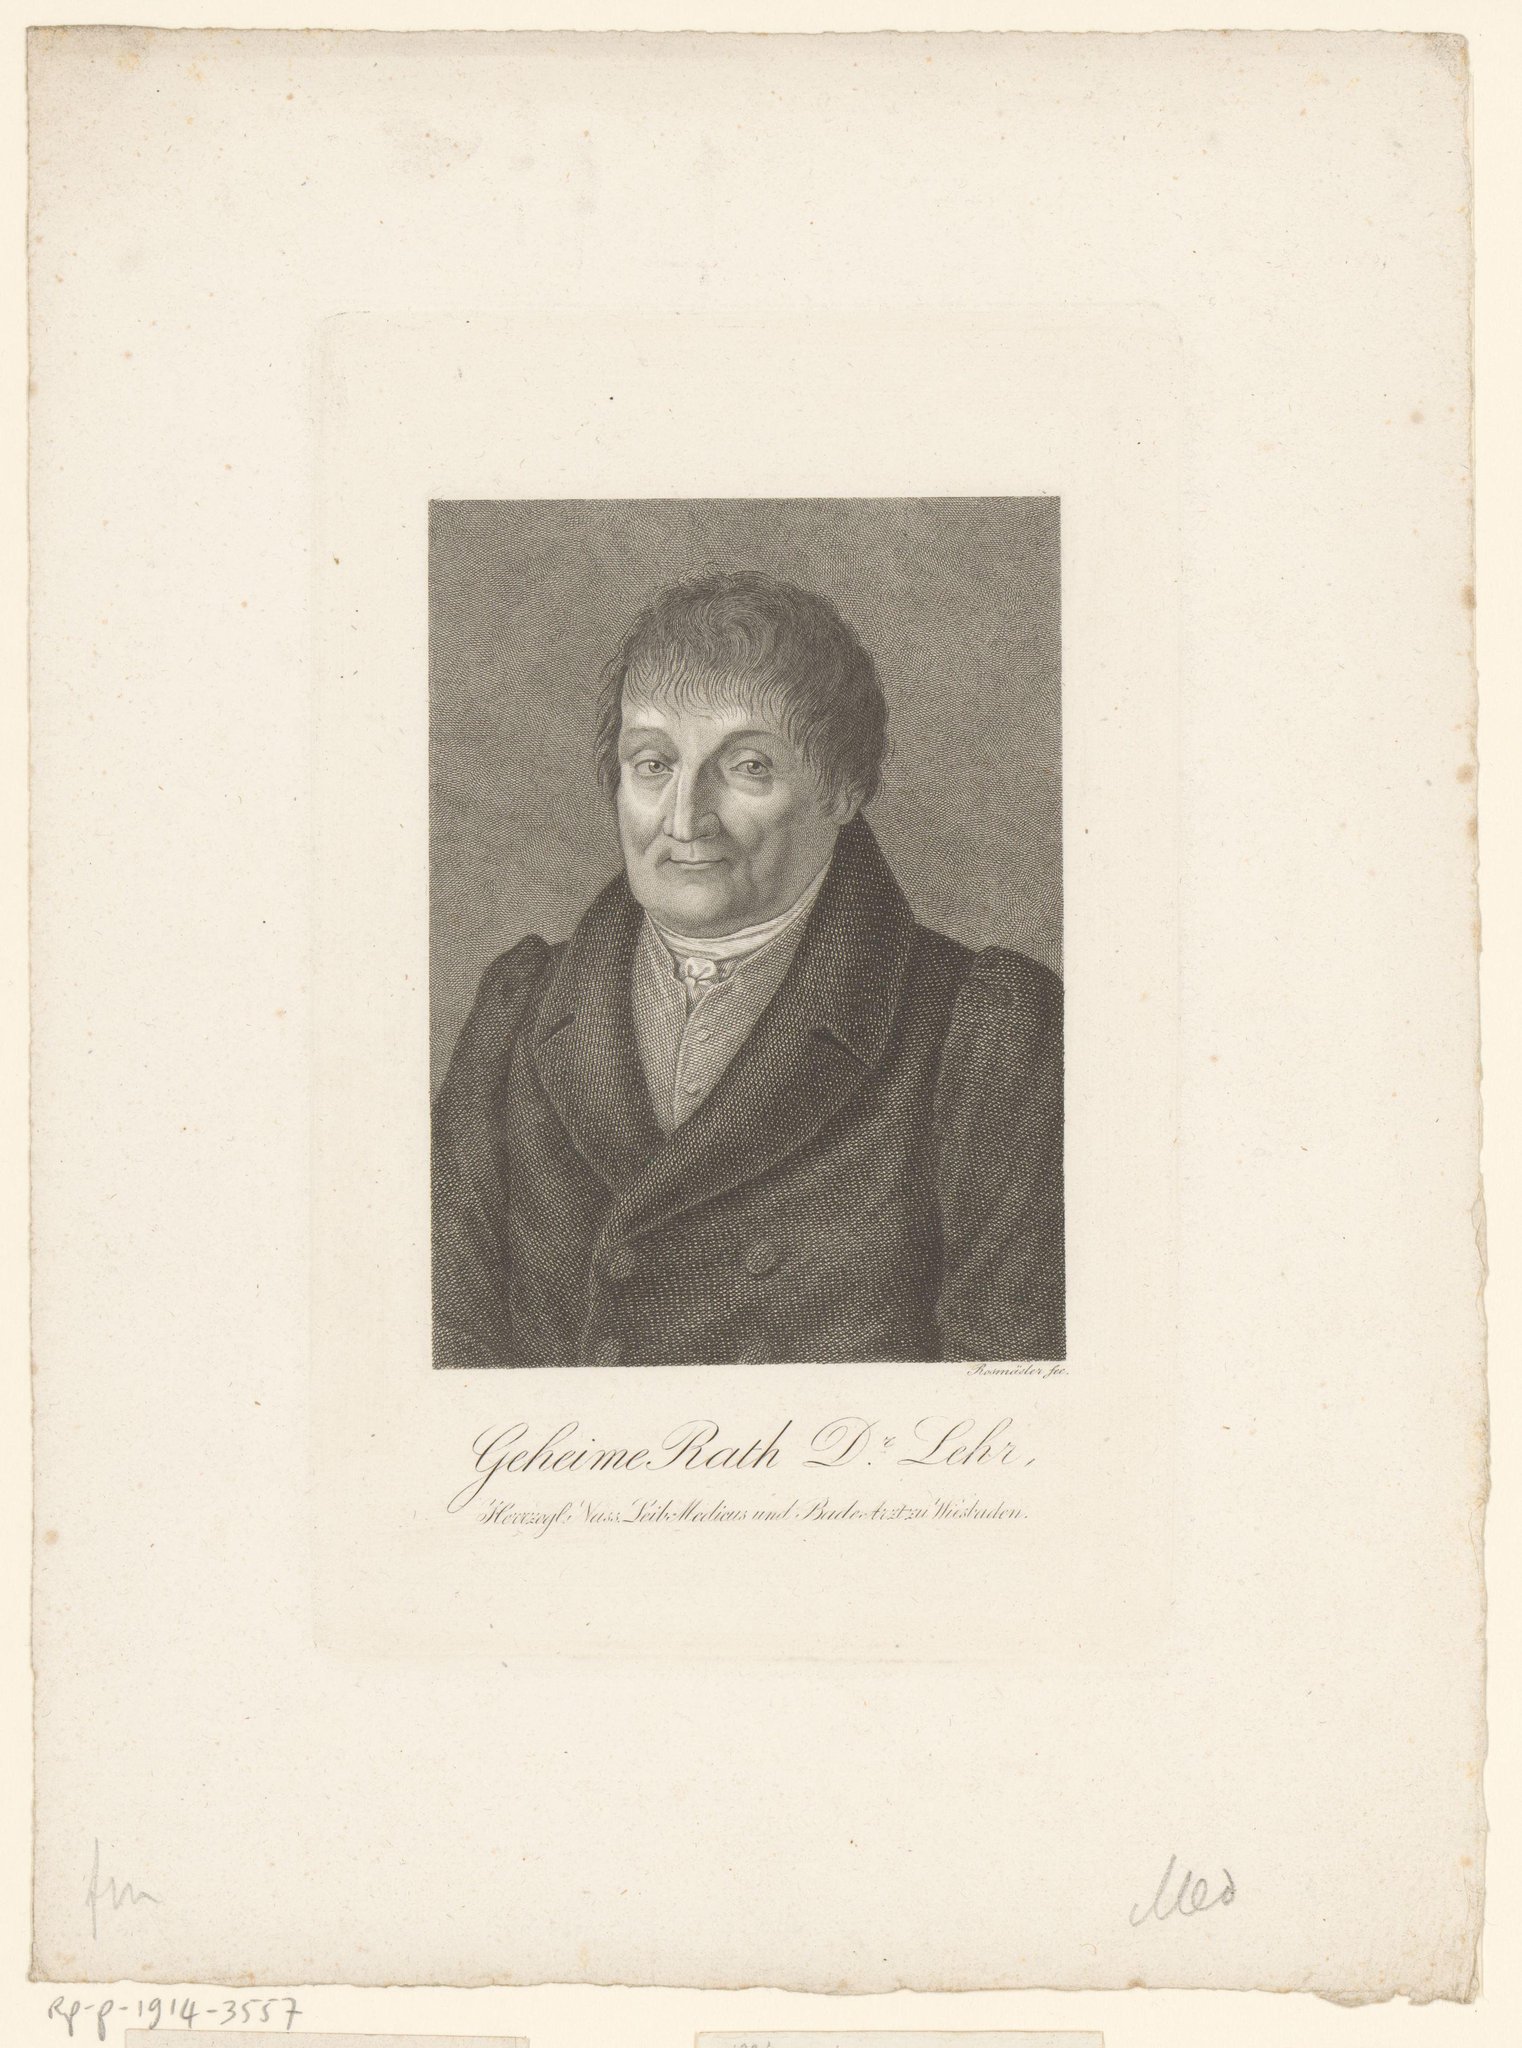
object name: print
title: Portret van Friedrich August Lehr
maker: friedrich rossmässler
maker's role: print maker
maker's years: 1775-1858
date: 1785-1858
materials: paper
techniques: engraving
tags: historical persons, physician, doctor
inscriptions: collector's mark: Lugt 2228